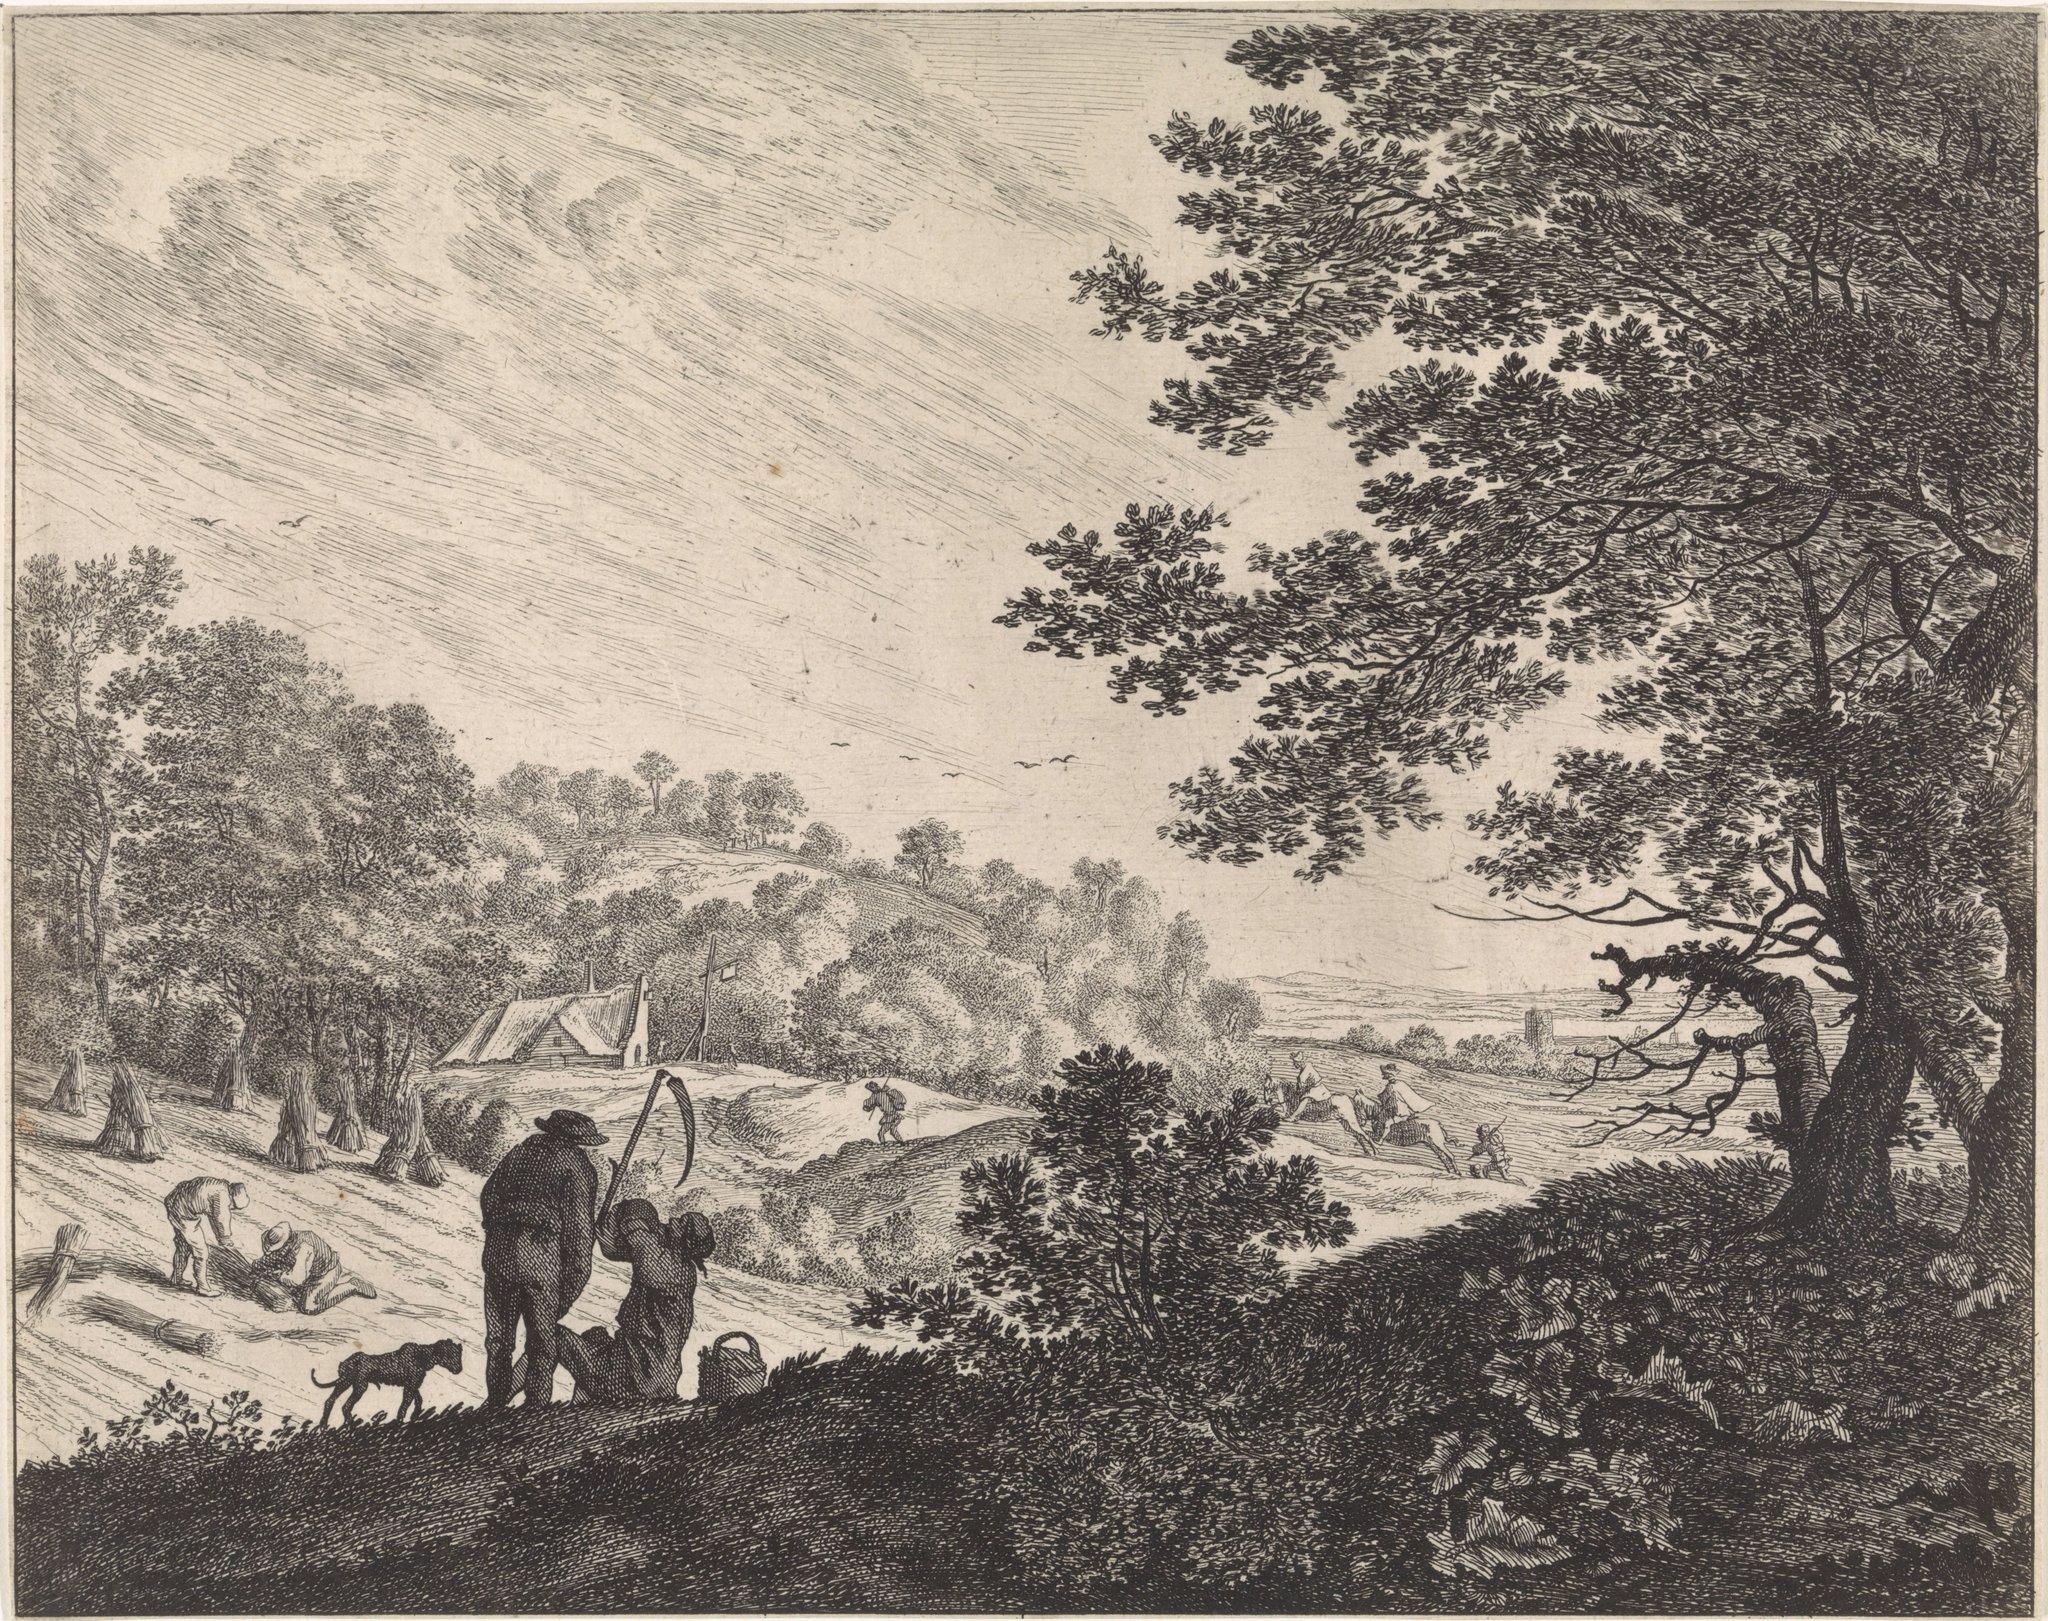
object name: print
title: Landschap met maaiers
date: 1623-1653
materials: paper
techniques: engraving, etching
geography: amsterdam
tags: reaping, picking, mowing ~ harvest (+ men (labourers)), riding a horse, ass, or mule; rider, horseman, landscapes in the temperate zone, cereal, grain, corn (grass with grains, grown for food, e.g.: wheat, rice, rye, oats, maize, buckwheat, millet), dog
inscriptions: collector's mark: Lugt 240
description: In een heuvelachtig landschap rusten twee maaiers uit, van wie één een kruik aan zijn mond zet en de ander een zeis in de hand houdt. Naast hen een hond. Twee andere maaiers binden de schoven bijeen op de akker. Op de achtergrond twee ruiters en een huis met een uithangbord.